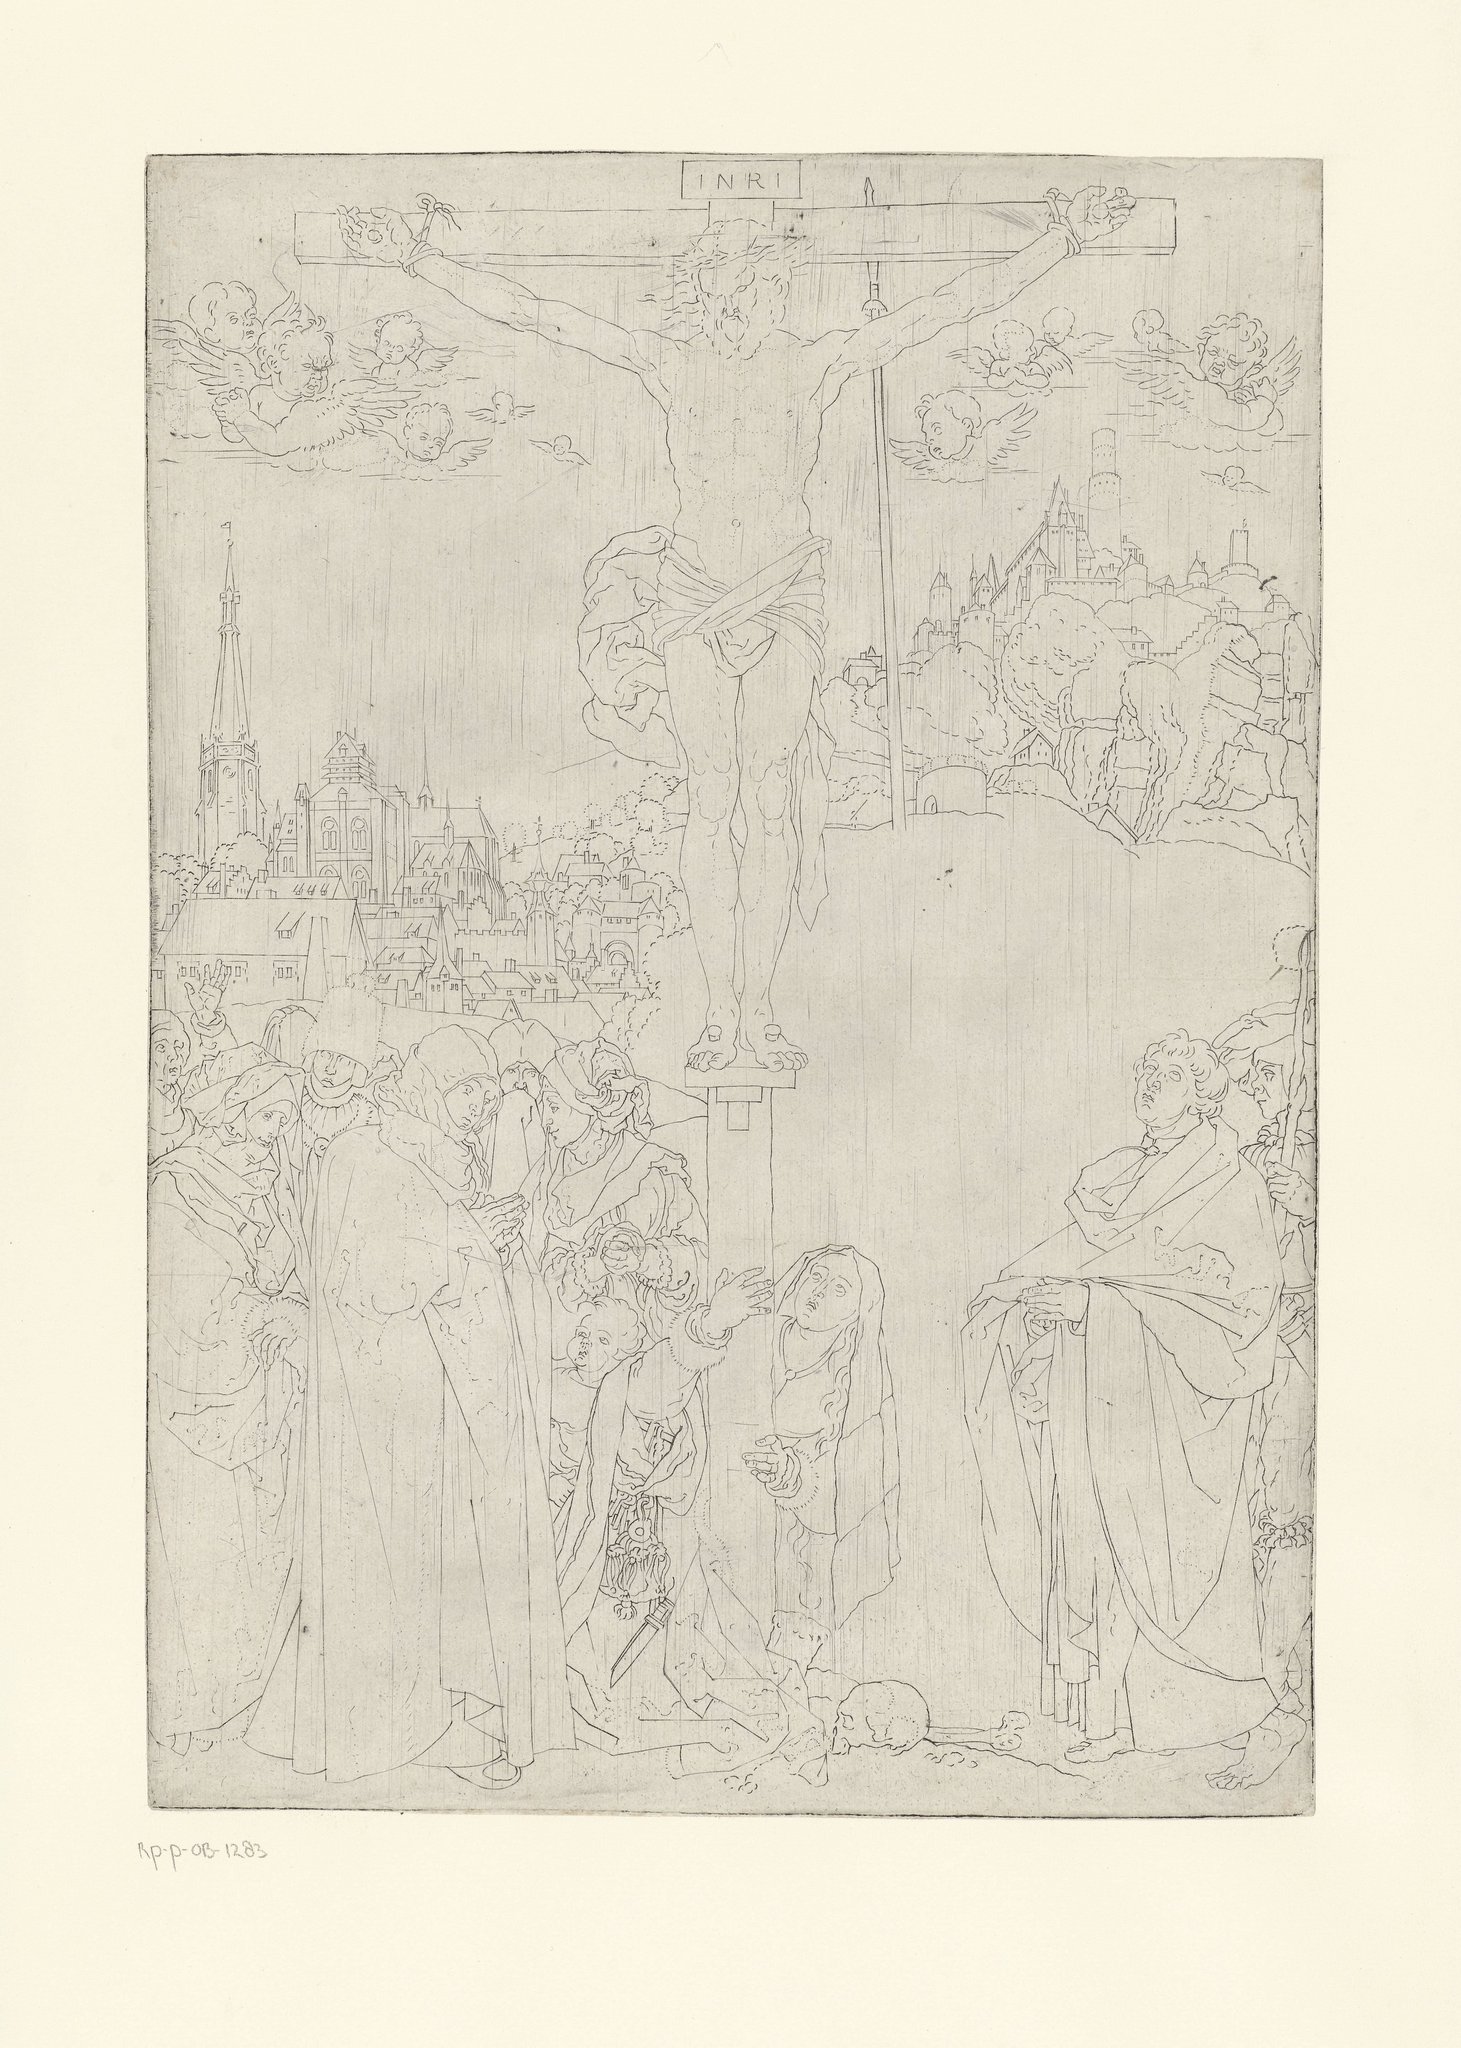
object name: print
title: De kruisiging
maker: albrecht dürer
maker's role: draughtsman, painter, print maker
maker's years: 1471-1528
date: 1521-1525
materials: paper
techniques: engraving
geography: nuremberg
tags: bystanders at the foot of the cross, among whom mary, mary magdalene and john the evangelist; mary may be shown swooning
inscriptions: inscription: ‘PH’, collector's mark: Lugt 240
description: Christus aan het kruis met vele omstanders. Aan zijn linkerzijde onder anderen Johannes de Evangelist, aan zijn rechterzijde onder anderen zijn moeder Maria, aan zijn voeten Maria Magdalena. Op de achtergrond huizen, een kerk en een burcht. Deze prent is onvoltooid, de voorstelling is alleen met contourlijnen aangeduid.